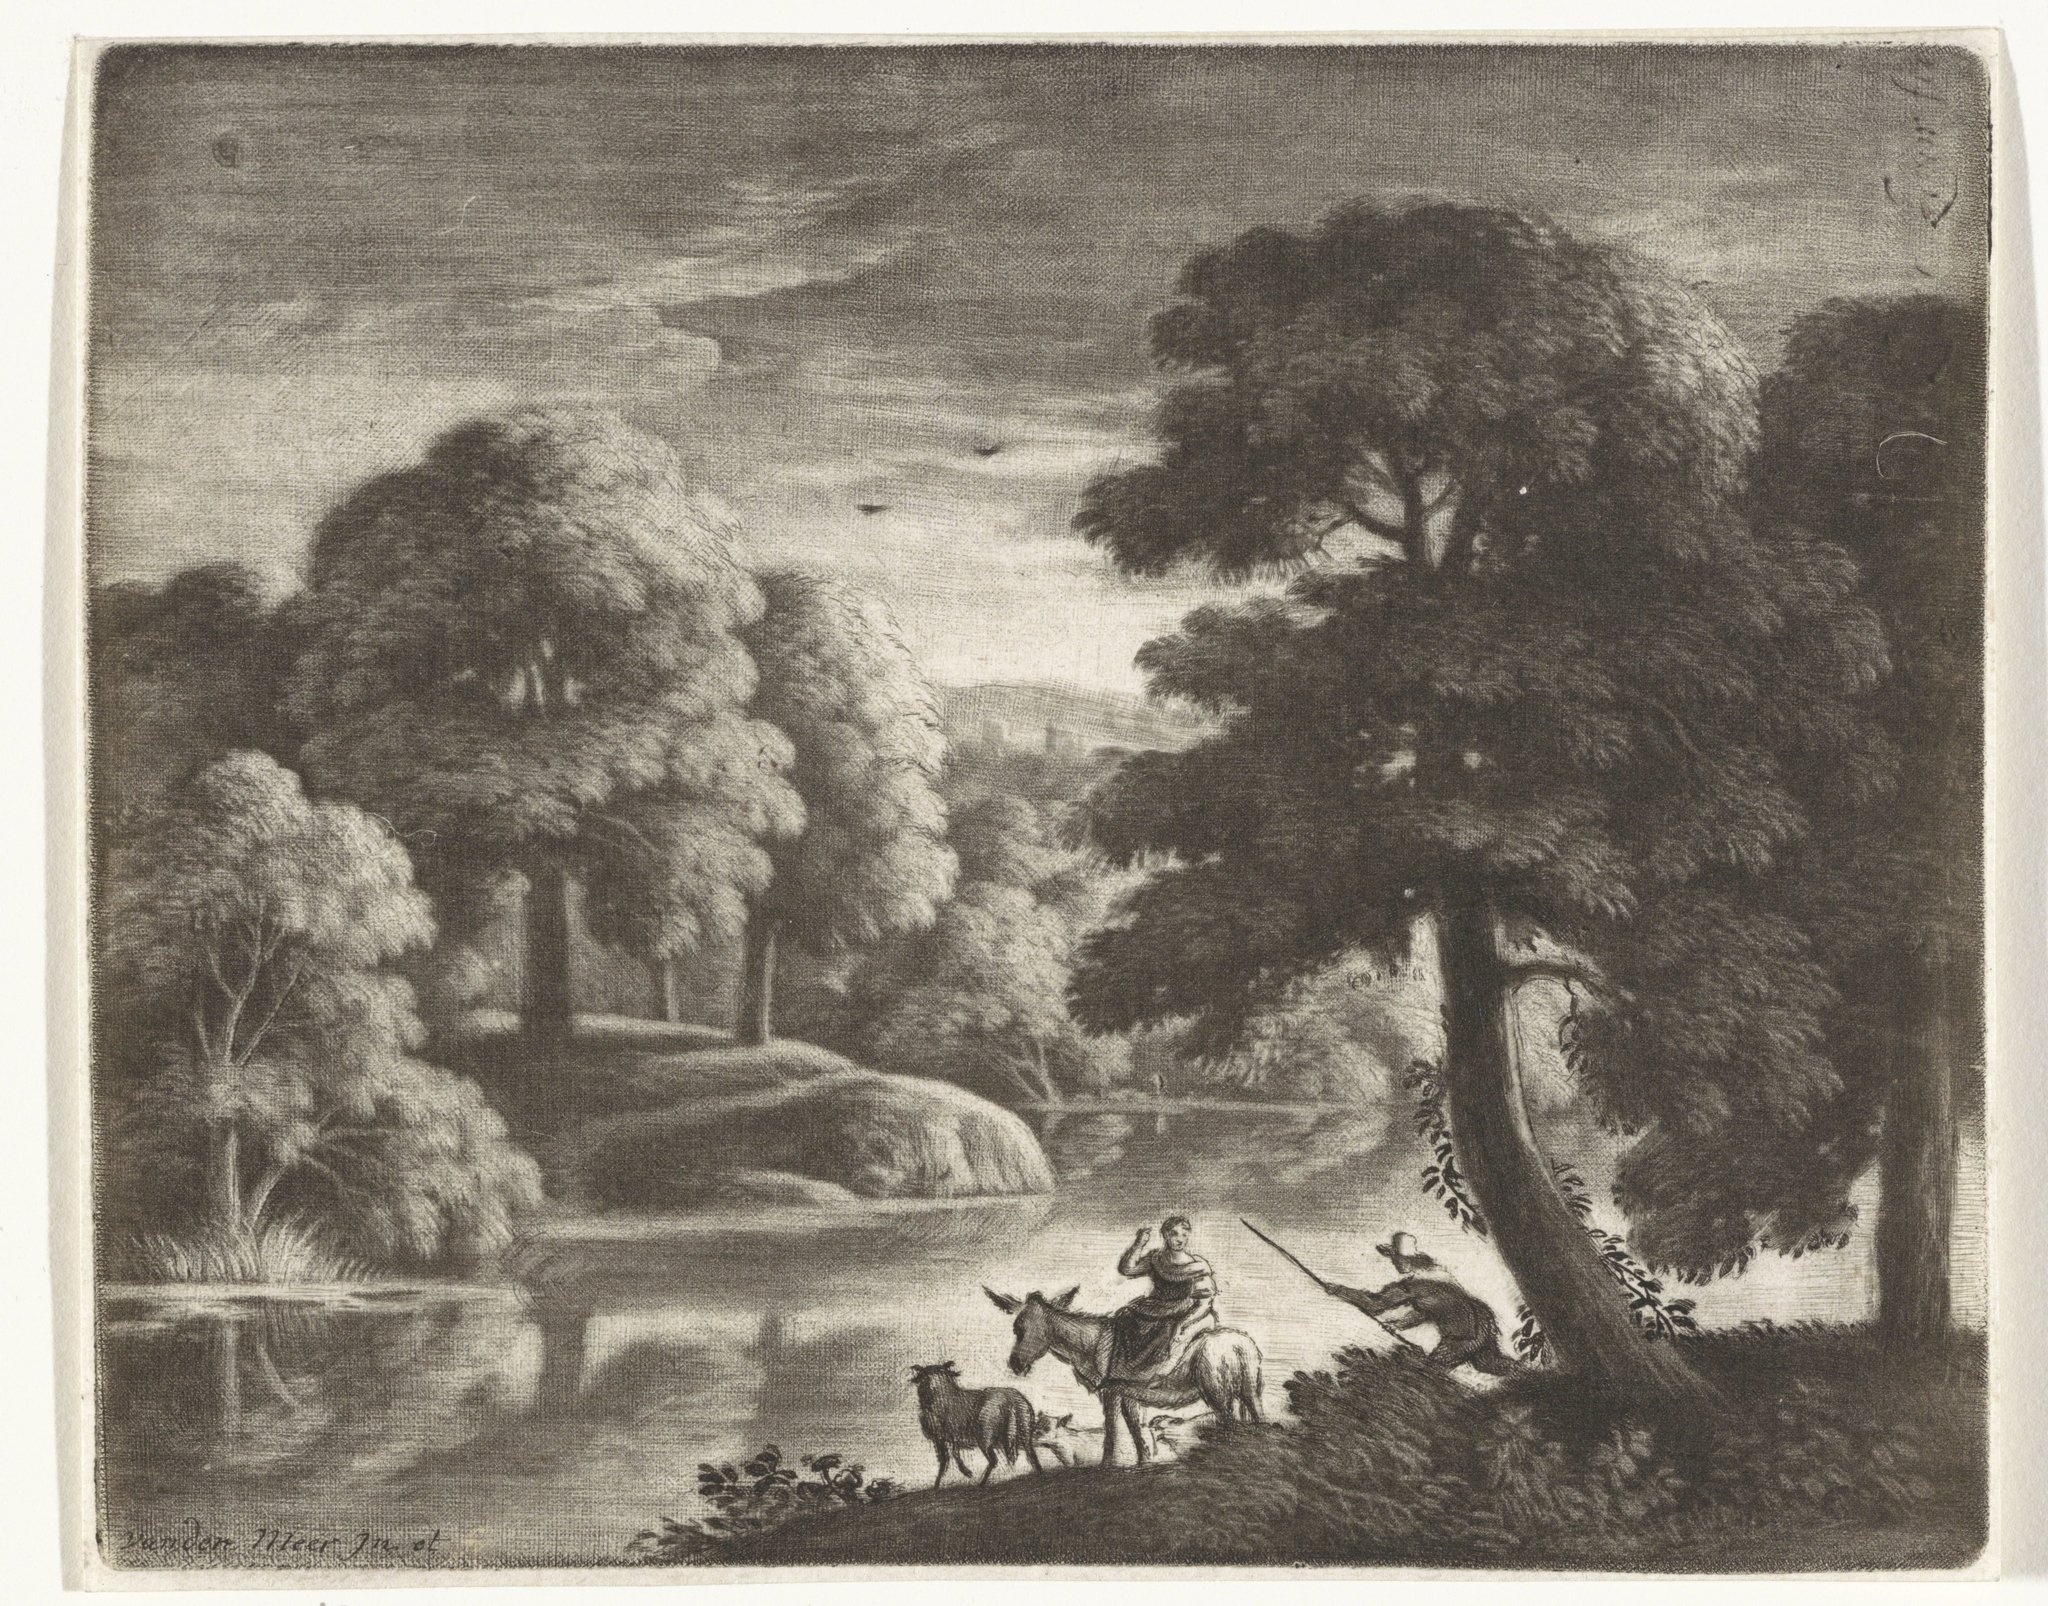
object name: print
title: Landschap met herder en herderin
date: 1743-1800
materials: paper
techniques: engraving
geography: amsterdam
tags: ass, donkey, herding, herdsman, herdswoman, shepherd, shepherdess, cowherd, etc., lake, forest, wood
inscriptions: collector's mark: Lugt 240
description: Gezicht op een boslandschap met een meer. Aan de rand van het water een herderin op een ezel en een herder met zijn herdersstok.